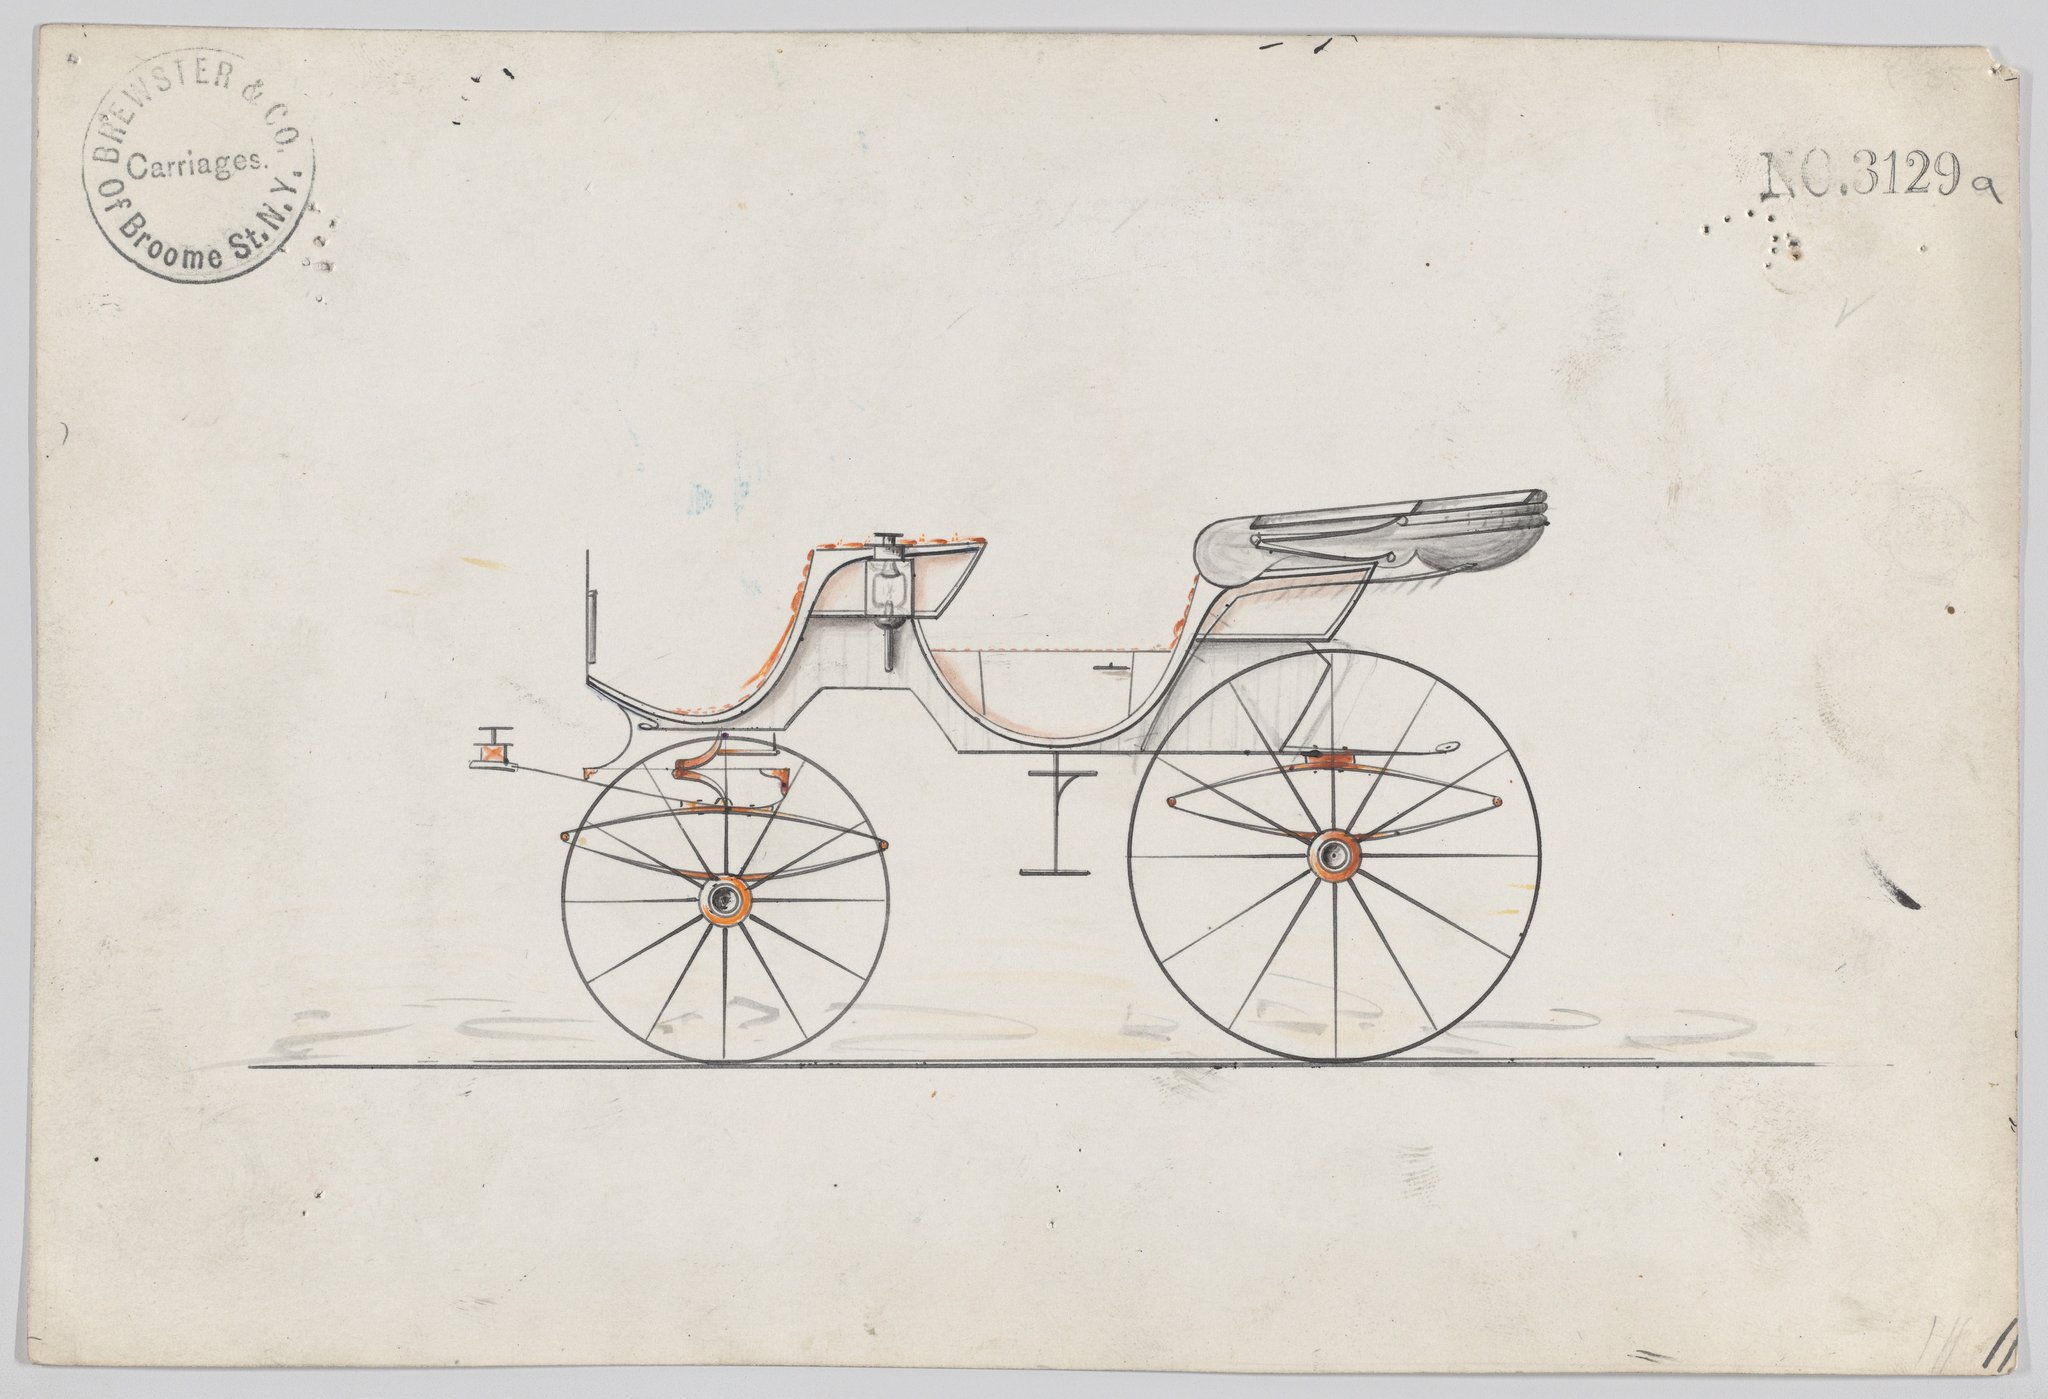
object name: drawing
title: Design for 2 seat Cabriolet Phaeton, no. 3129a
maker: brewster & co.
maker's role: manufacturer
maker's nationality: american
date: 1875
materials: graphite, ink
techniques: pen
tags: carriages